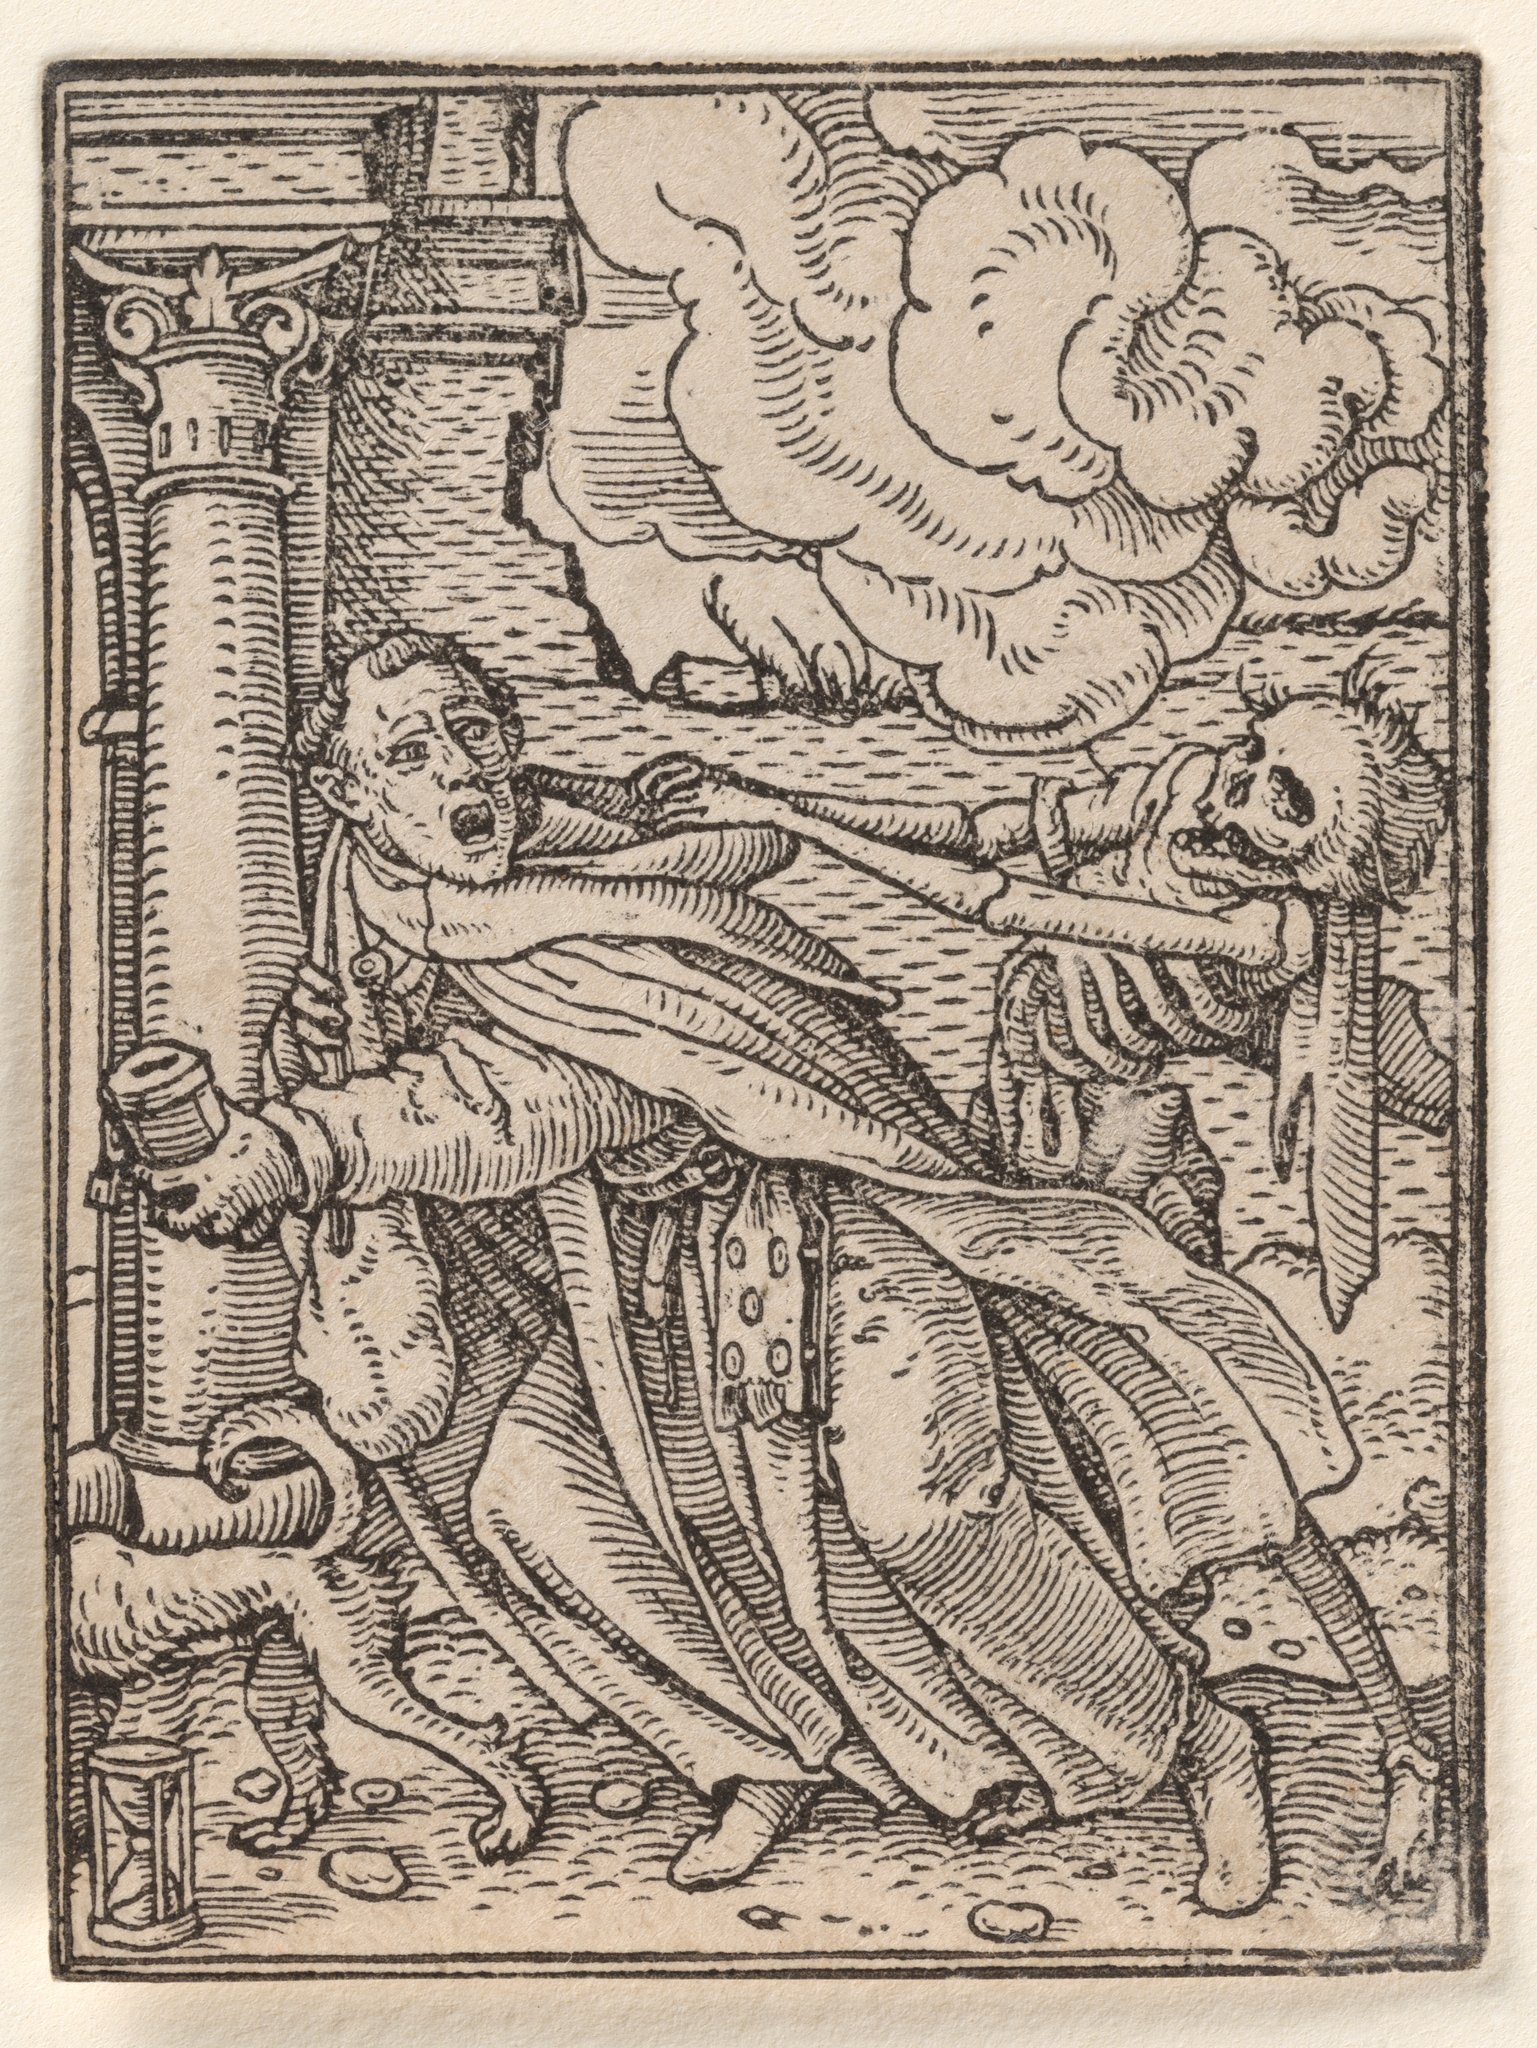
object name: print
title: The Monk (or Mendicant), from "The Dance of Death"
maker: hans holbein the younger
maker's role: artist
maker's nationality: german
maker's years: 1497-1543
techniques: woodcut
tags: skeletons,men,monks,hourglass